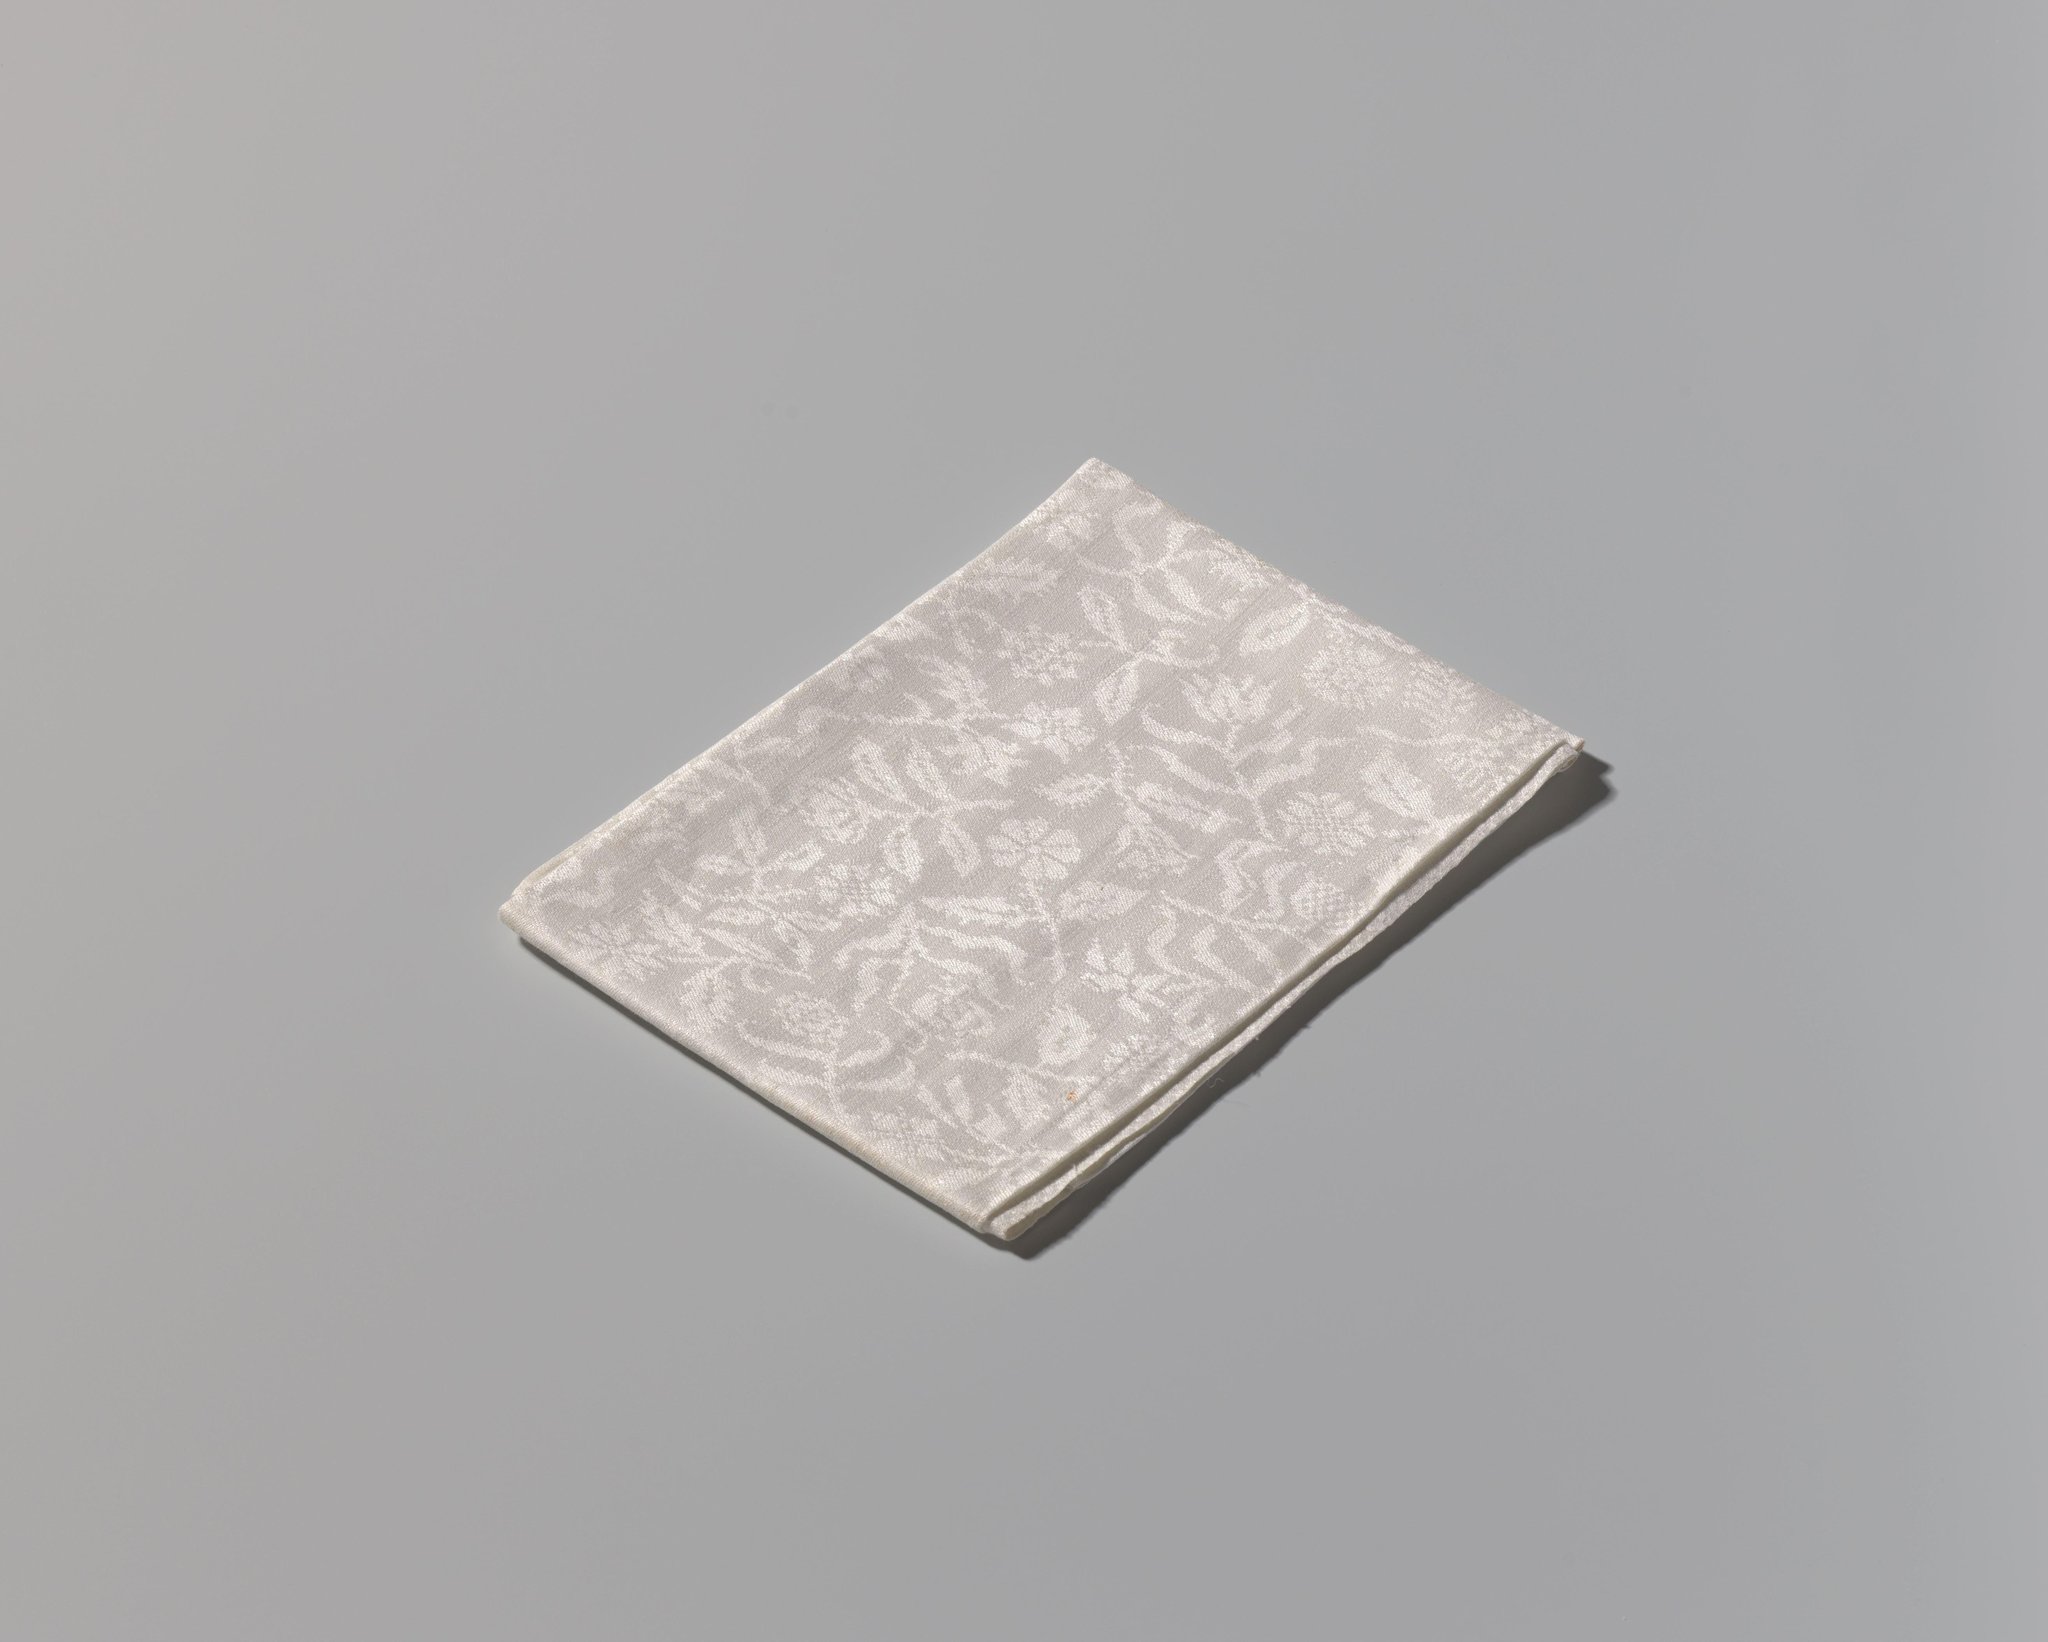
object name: napkin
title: Servet met een bloempatroon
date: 1650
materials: linen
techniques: damask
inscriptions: mark: ‘12’, mark: ‘MJU**-’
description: Servet van linnendamast met een bloempatroon. Middenveld: Het symmetrisch patroon vertoont losse takken met rozen of tulpen, en kievits- of rozetvormige bloemen. Staande randen: symmetrische tekening van slingerende bloemranken en vogels; daarbuiten: blokkenrand.